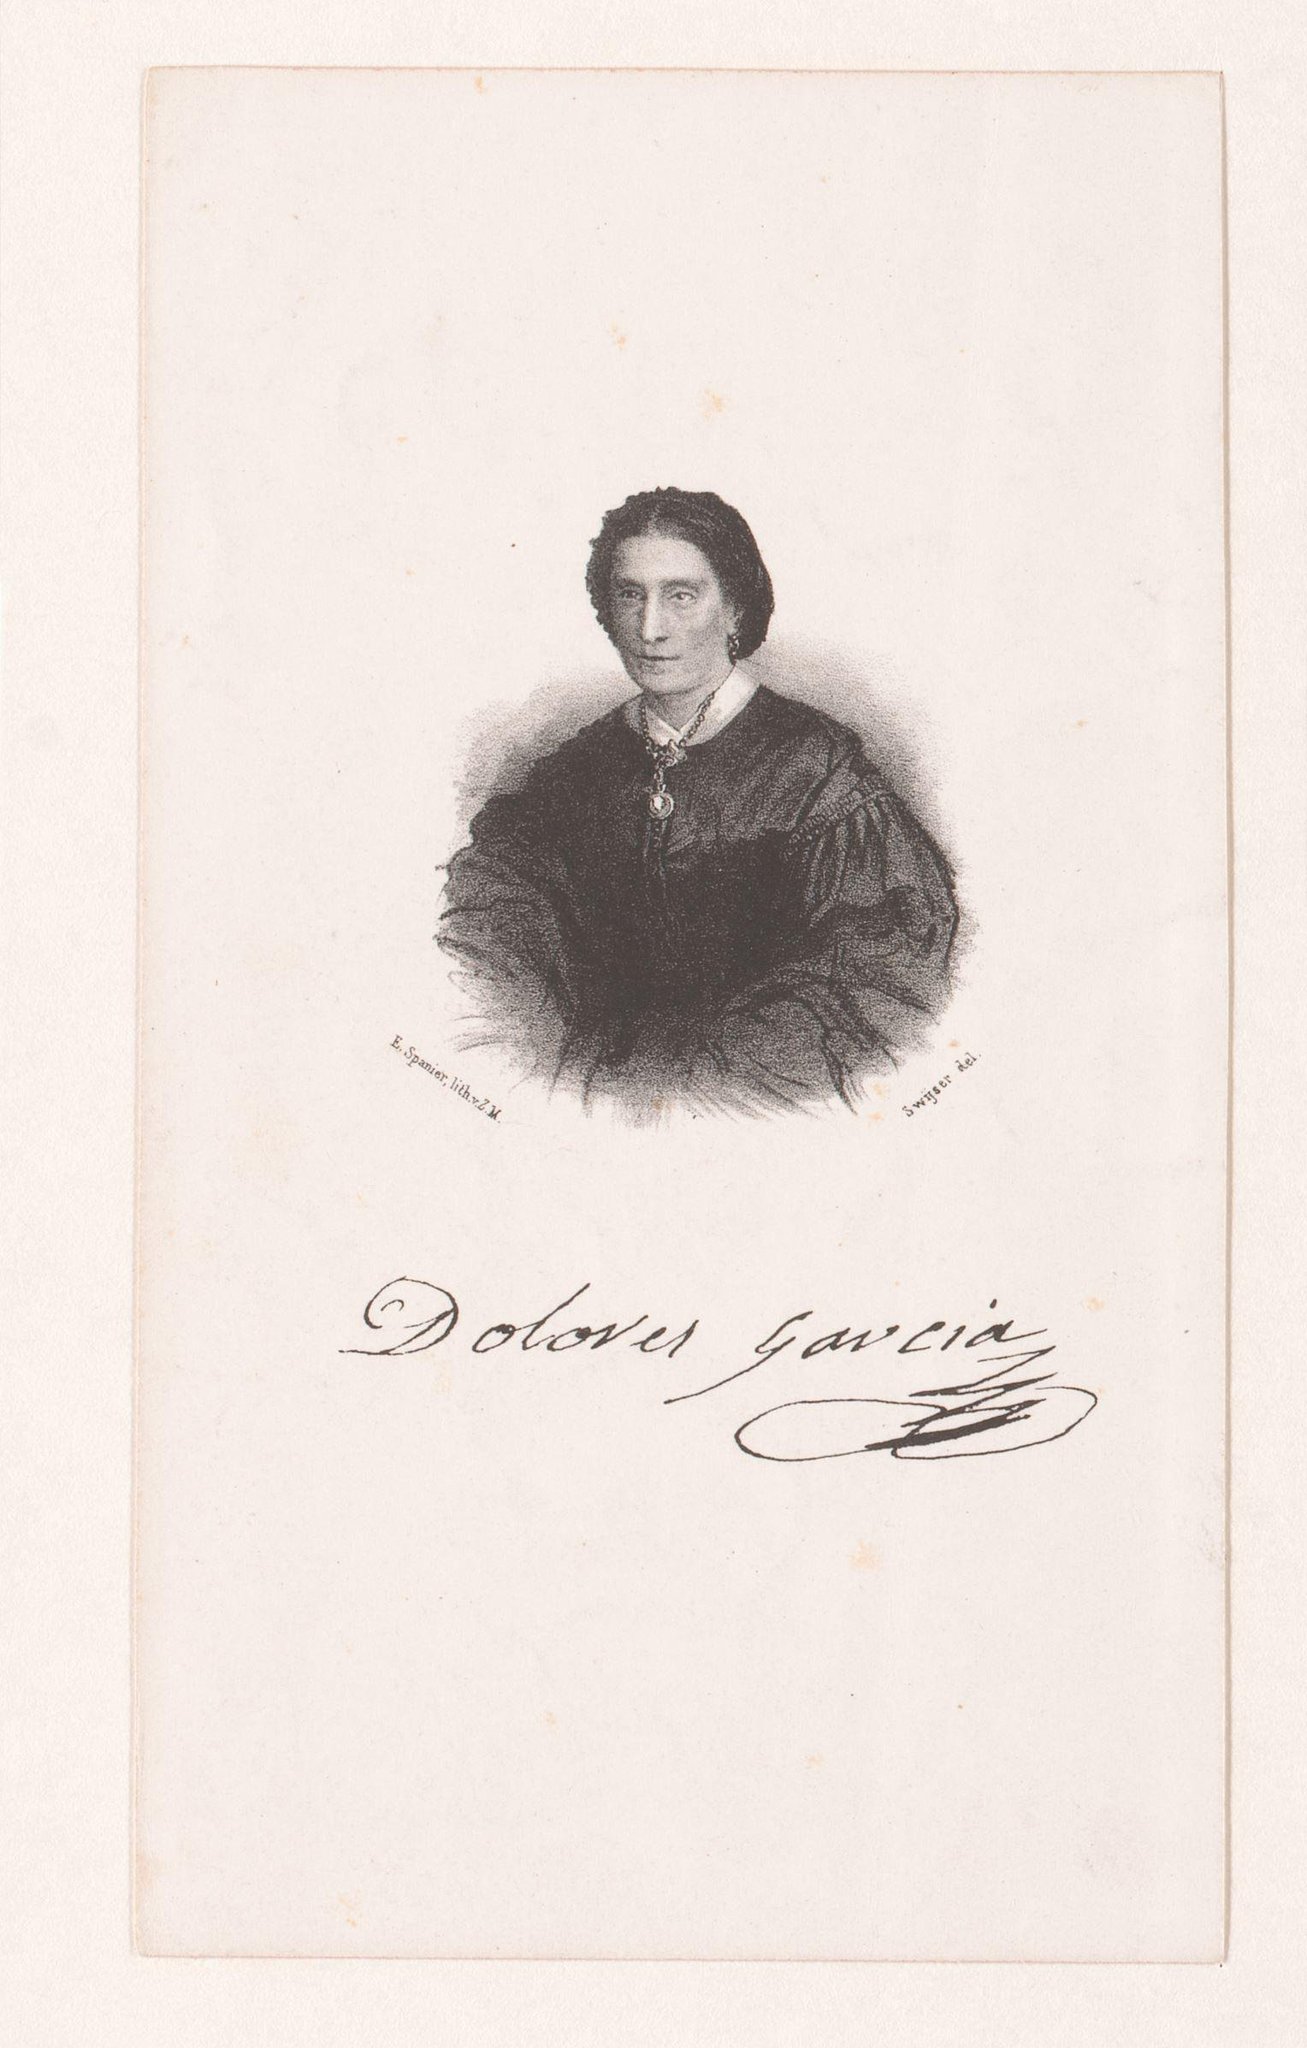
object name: print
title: Portret van Dolores Garcia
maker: elias spanier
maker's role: print maker, printer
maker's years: 1821-1863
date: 1831-1863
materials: paper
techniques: lithograph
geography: the hague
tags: historical persons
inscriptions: collector's mark: Lugt 2228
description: Onder het portret de signatuur van de geportretteerde.